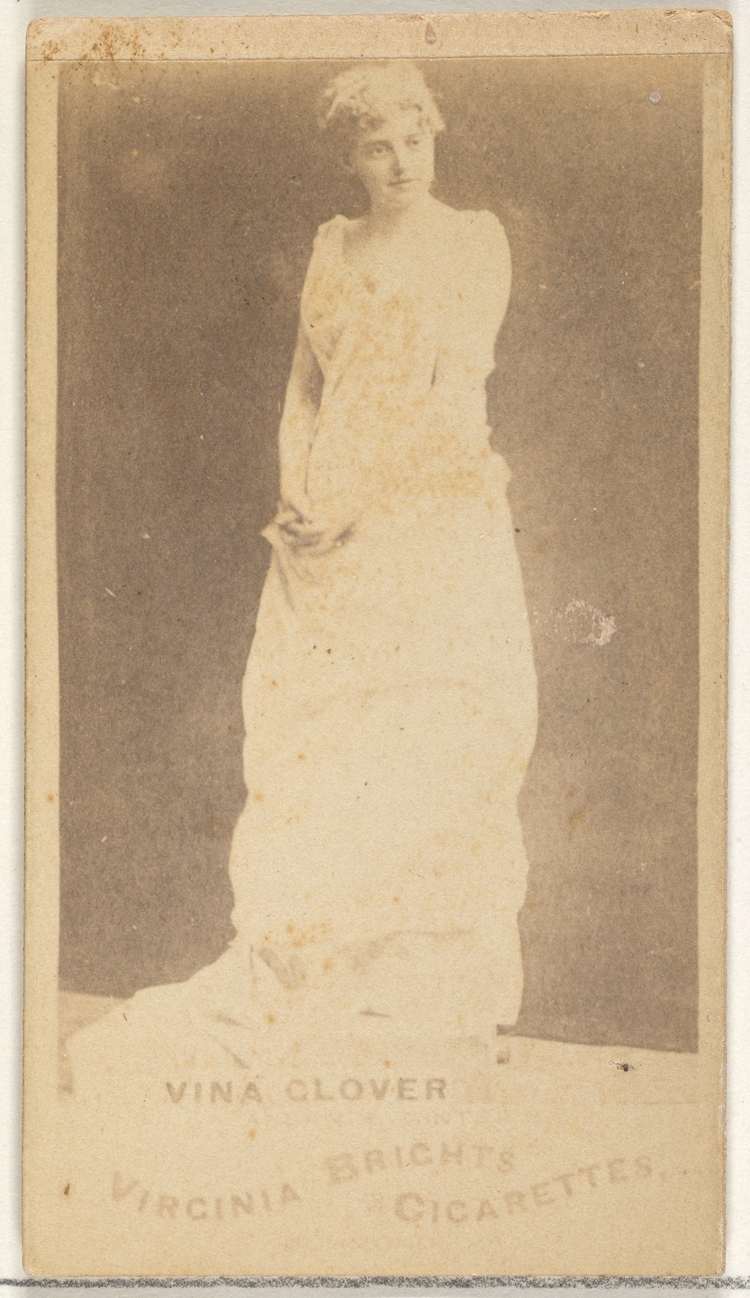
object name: photograph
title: Vina Glover, from the Actors and Actresses series (N45, Type 1) for Virginia Brights Cigarettes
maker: allen & ginter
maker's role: publisher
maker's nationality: american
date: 1888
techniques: albumen silver print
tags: portraits,women,actresses